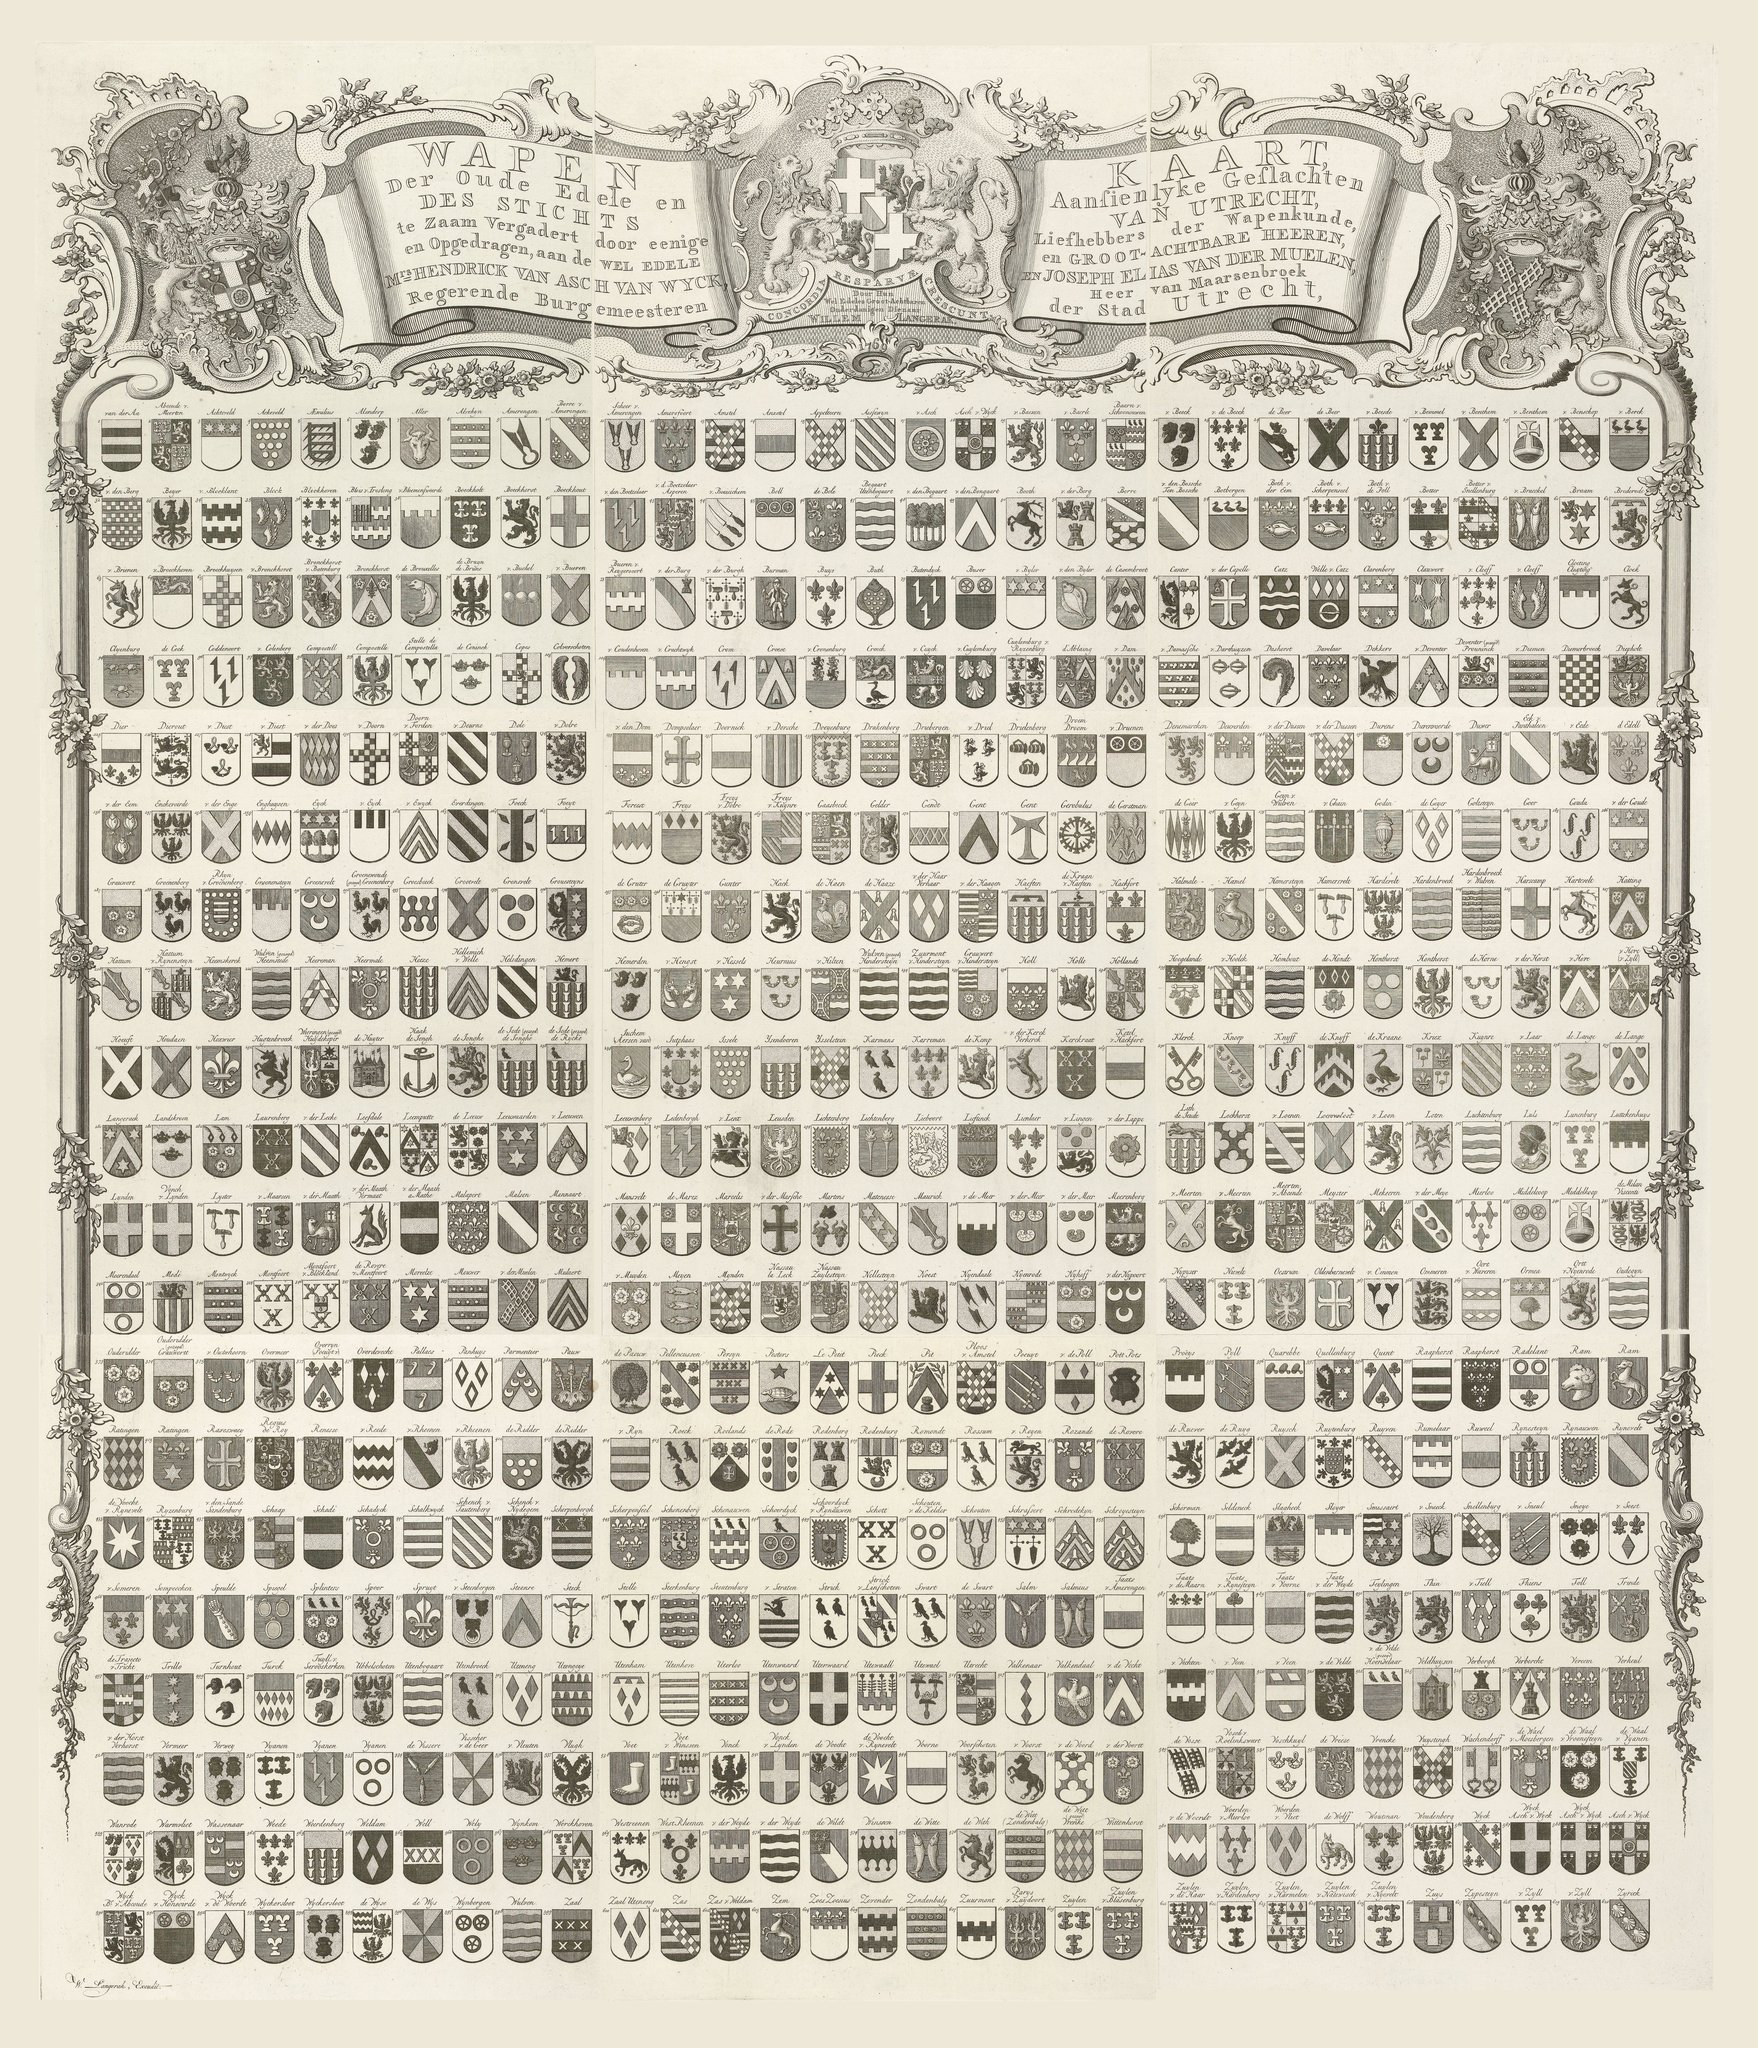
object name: print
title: Wapen Kaart Der Oude Edele en Aansienlijke Geslachten Des Stichts Van Utrecht te Zaam Vergadert door eenige Liefhebbers der Wapenkunde, en Opgedragen, aan de wel edele en groot-achtbare heeren Mrs. Hendrick van Asch van Wyck, en Joseph Elias van der Muelen, Regerende Burgemeesteren der Stad Utrecht,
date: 1769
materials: paper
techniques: engraving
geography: utrecht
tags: armorial bearing, heraldry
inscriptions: collector's mark: Lugt 2228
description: Negen afzonderlijke bladen, elk genummerd rechtsonder, vormen samen een geheel van wapens met bijbehorende namen. Bovenaan op de de bladen links- midden- en rechtsboven een achtregelige tekst in het Nederlands met in het midden het wapen van Utrecht.